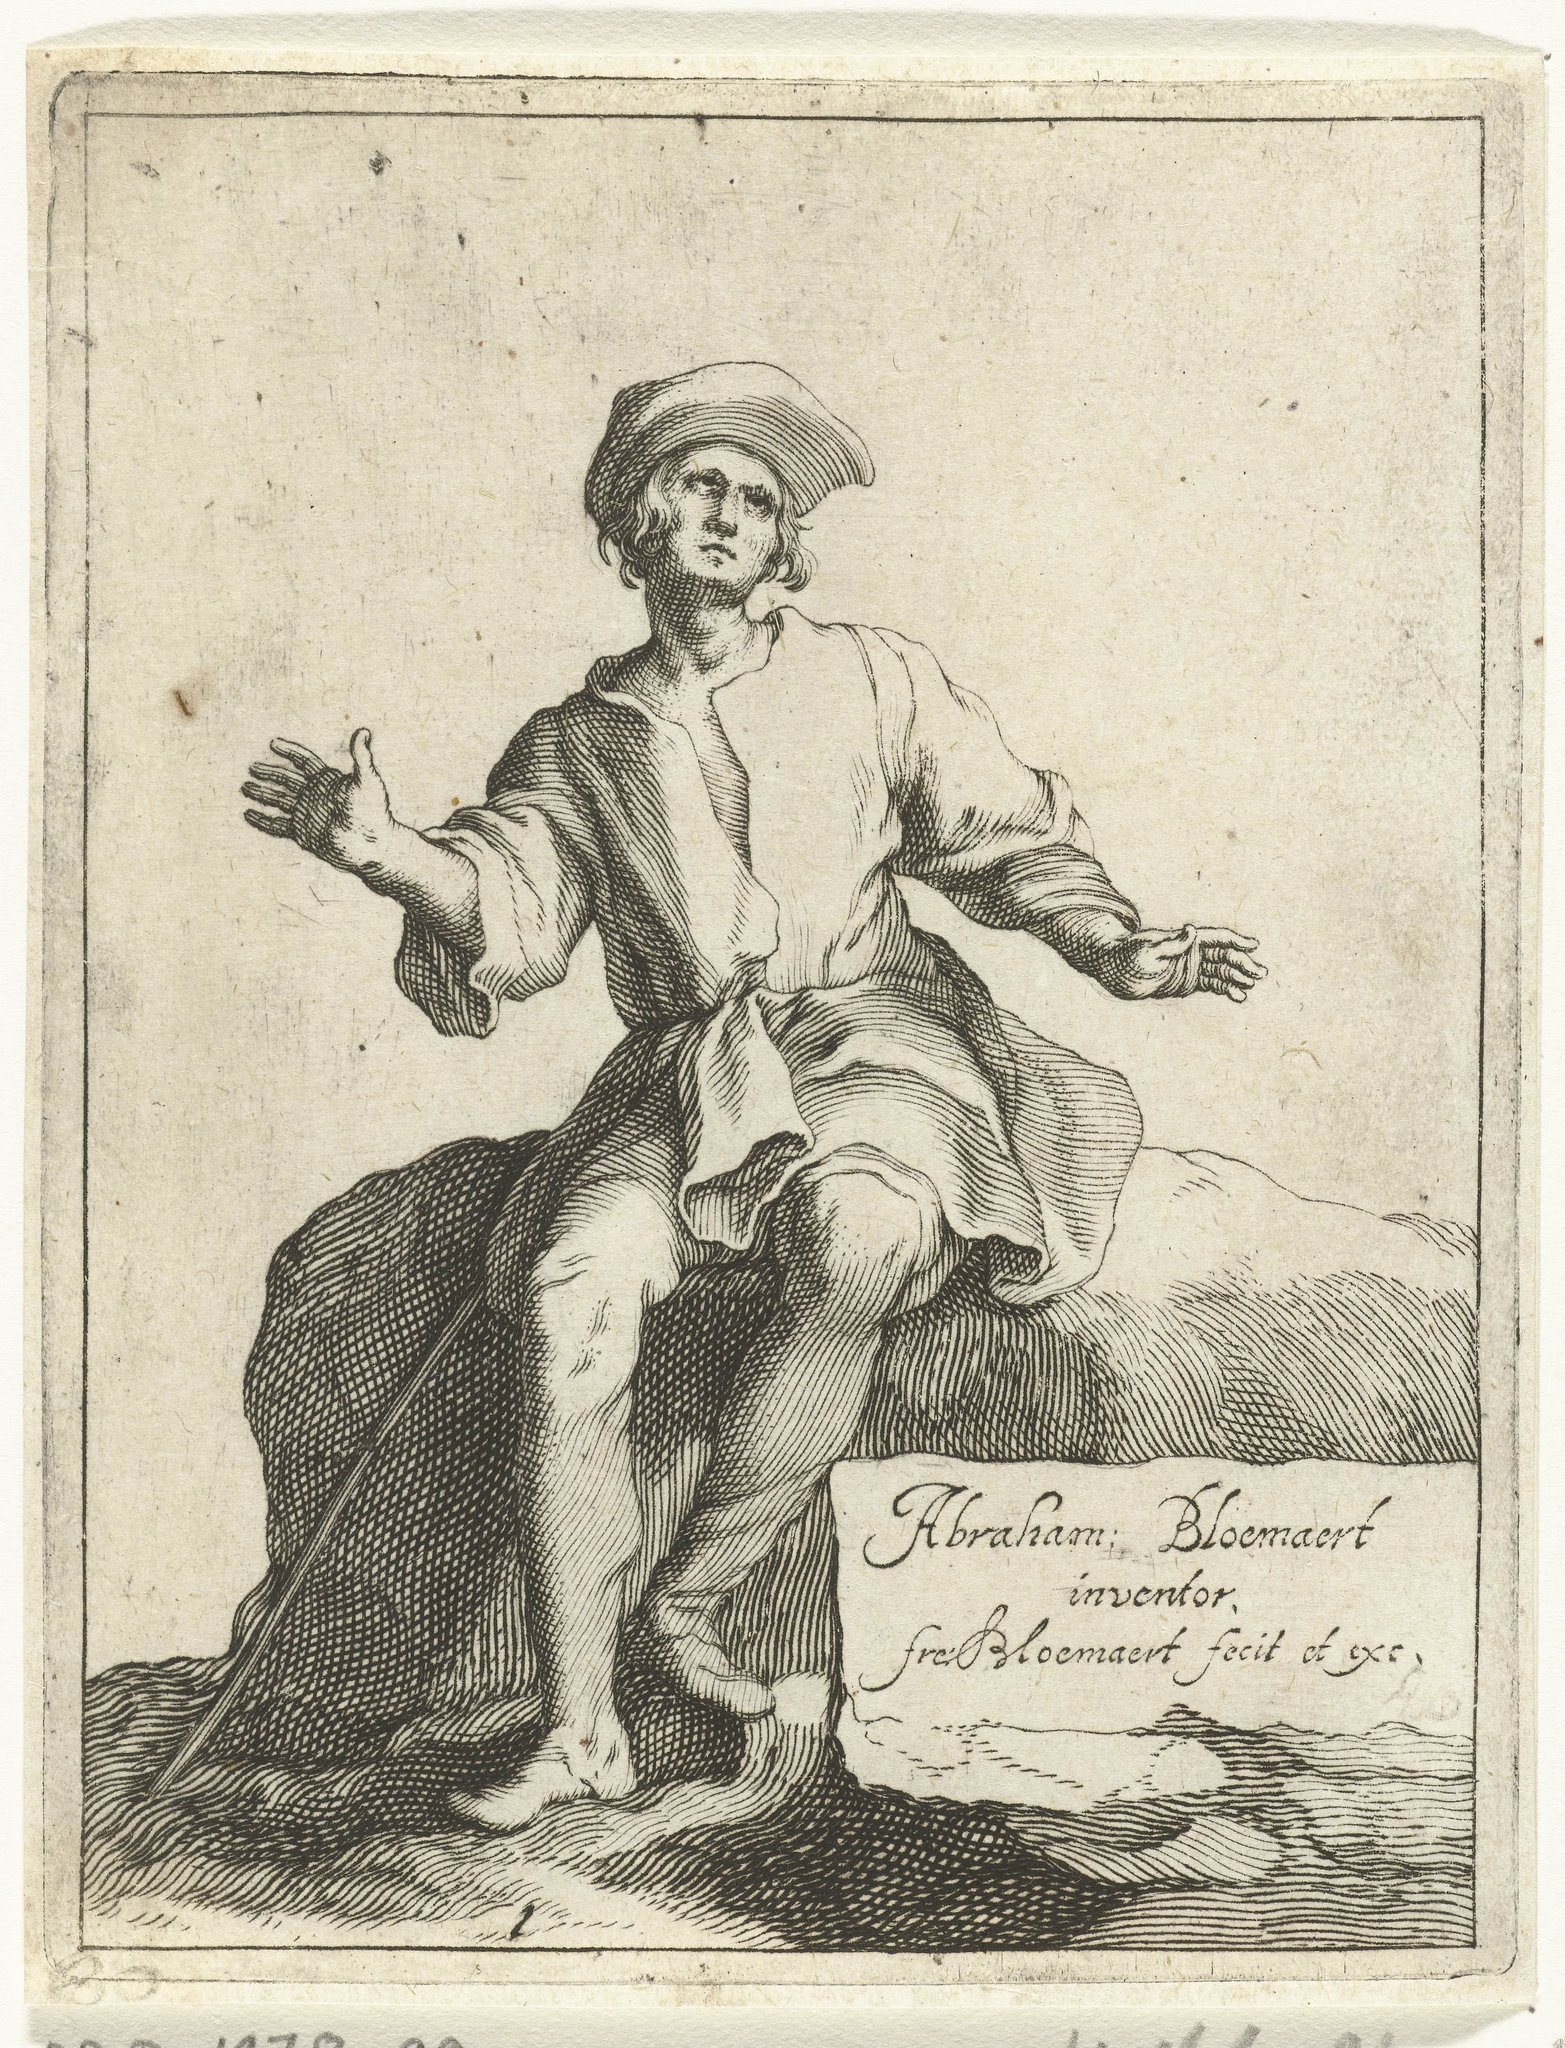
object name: titelprent, frontispice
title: Zittende man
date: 1635-1669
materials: paper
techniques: engraving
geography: utrecht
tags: farmers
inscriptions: collector's mark: Lugt 2228, collector's mark: Lugt 2760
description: Een man zit op een rotsblok, een stok naast hem, de ogen wat opgeslagen naar boven.